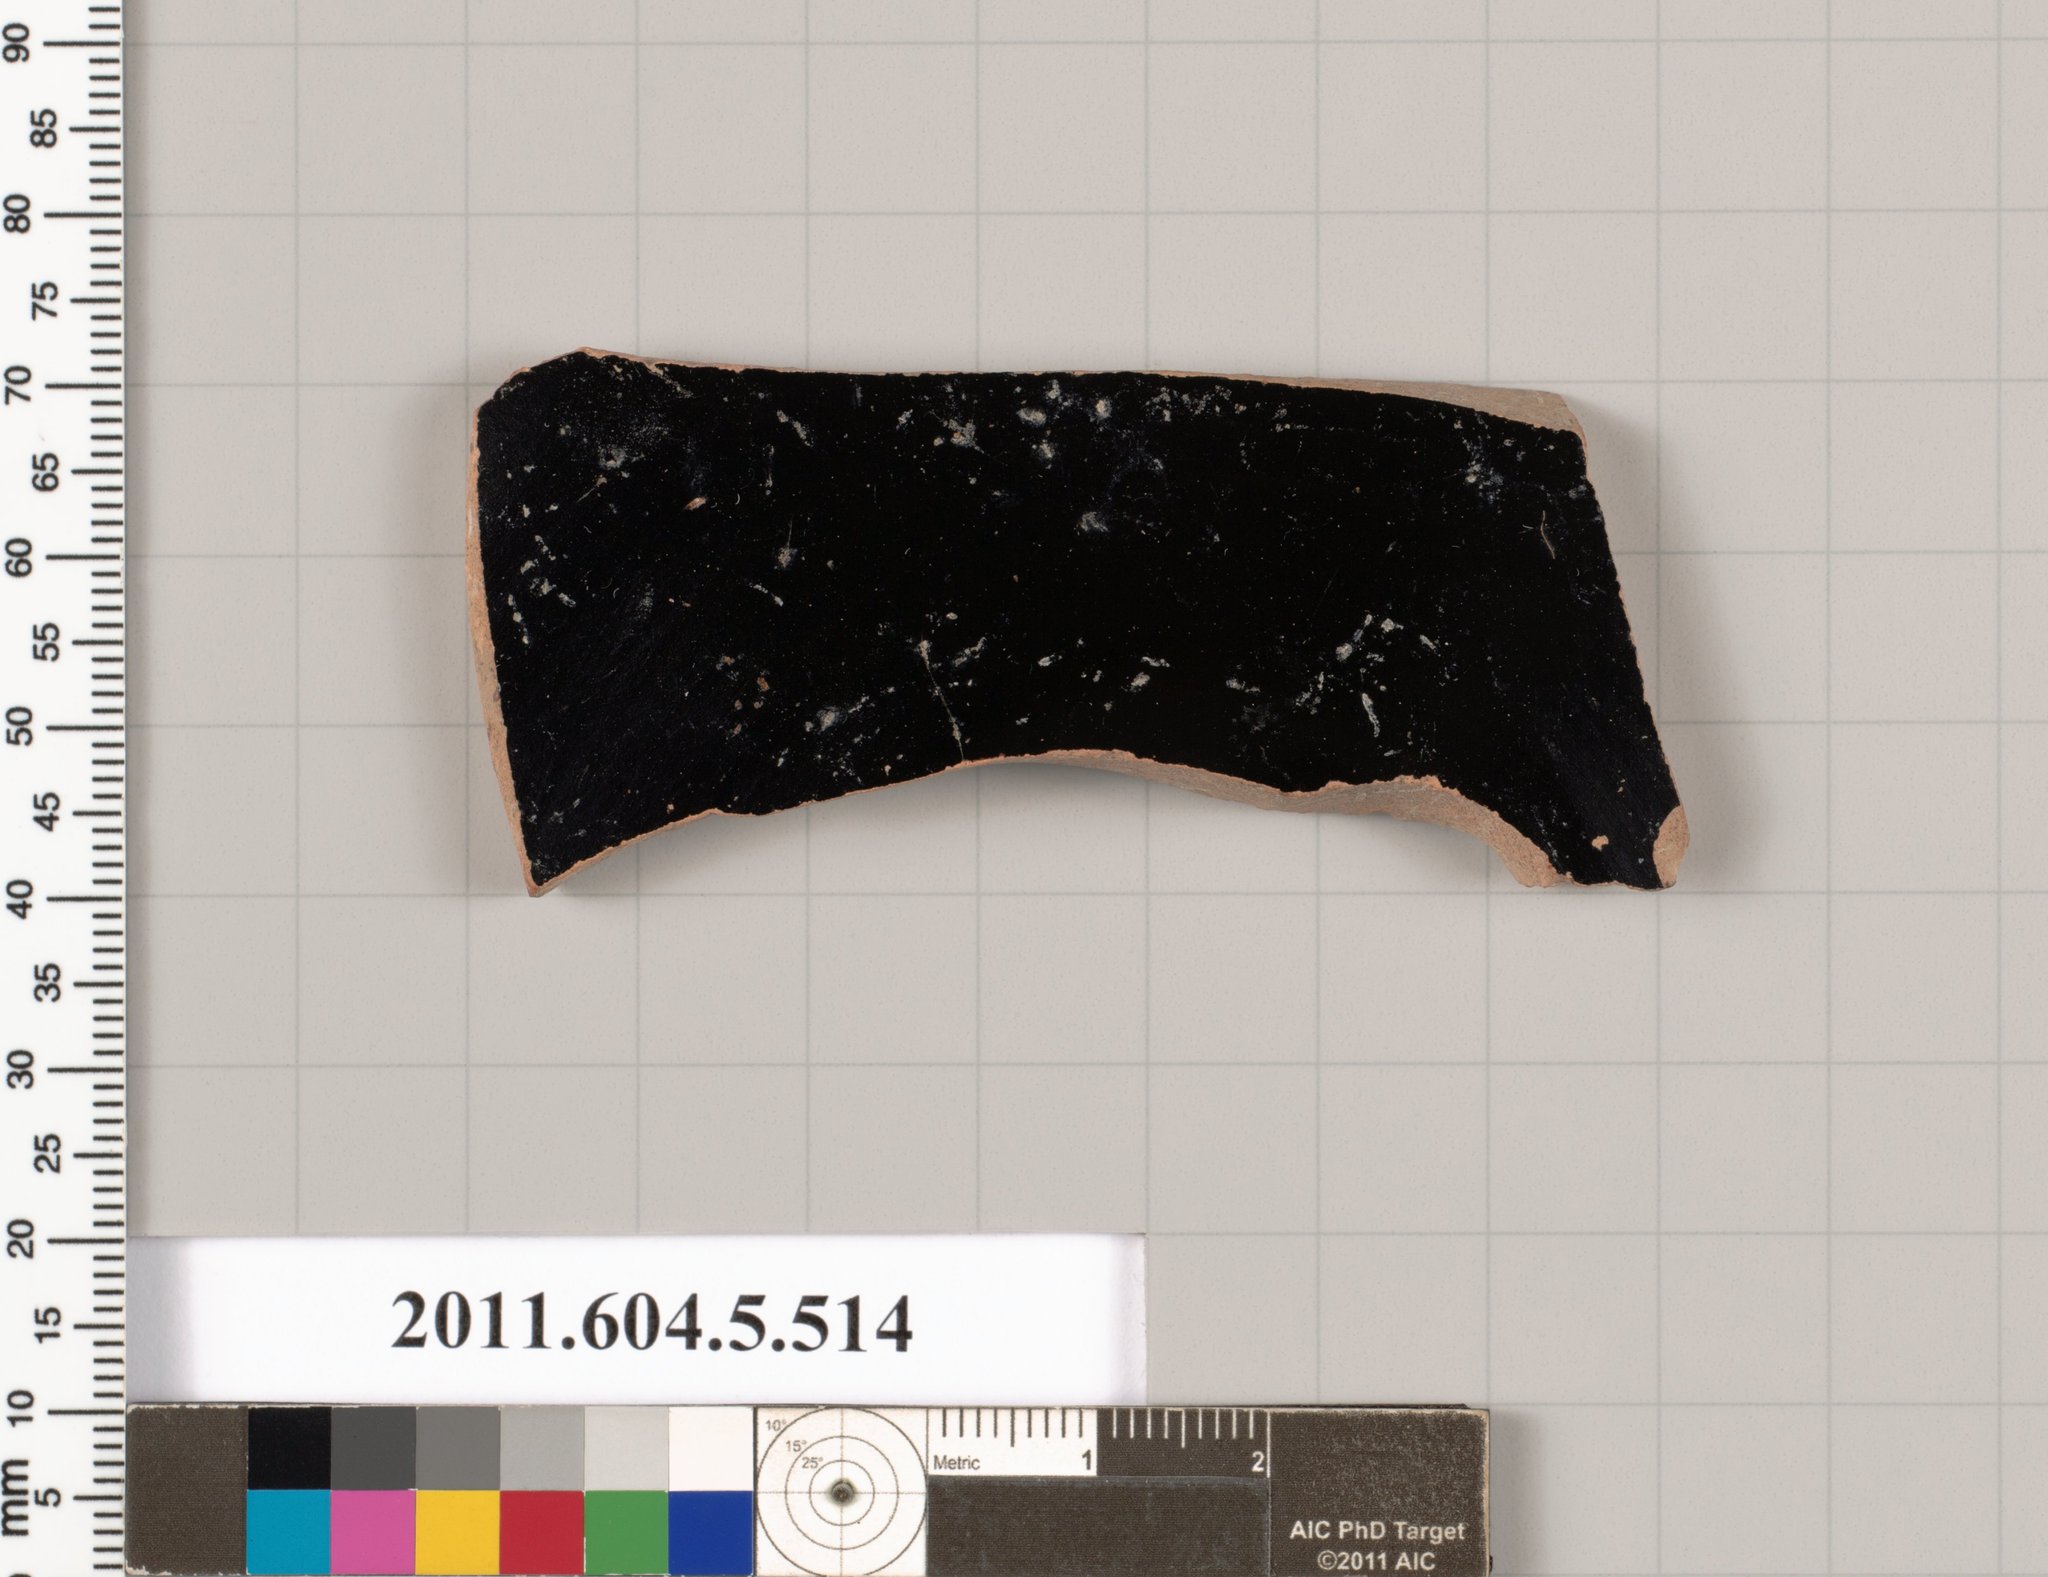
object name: kylix fragment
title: Terracotta fragment of a kylix (drinking cup)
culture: greek, attic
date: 600-401 BCE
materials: terracotta